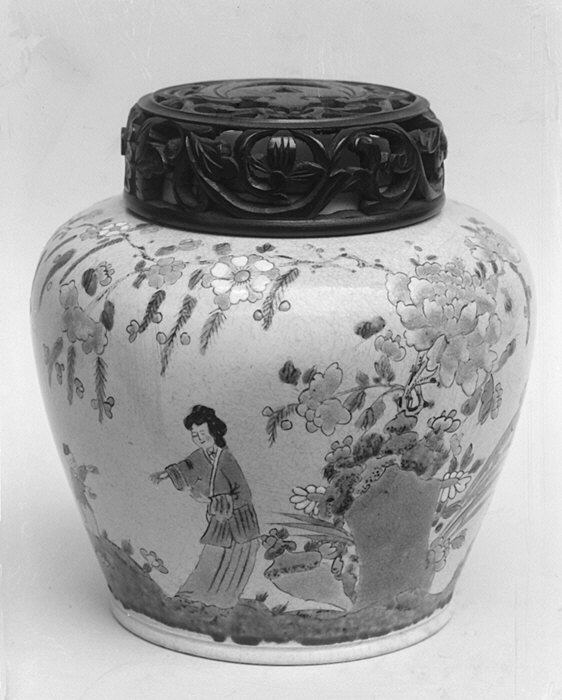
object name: vase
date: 1750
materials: stoneware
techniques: salt glaze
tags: women,flowers